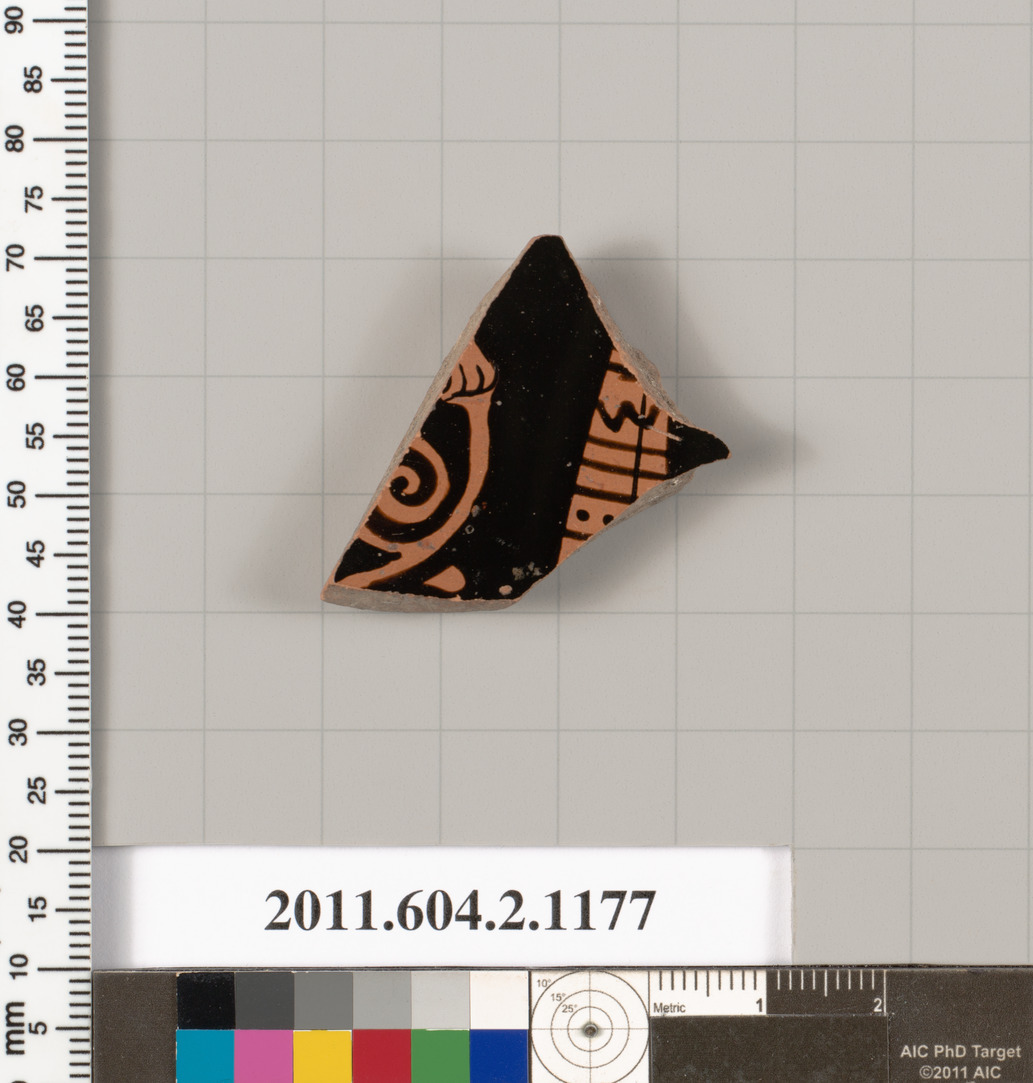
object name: lekanis fragment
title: Terracotta fragment of a lekanis lid (covered dish)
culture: greek, attic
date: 450-401 BCE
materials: terracotta